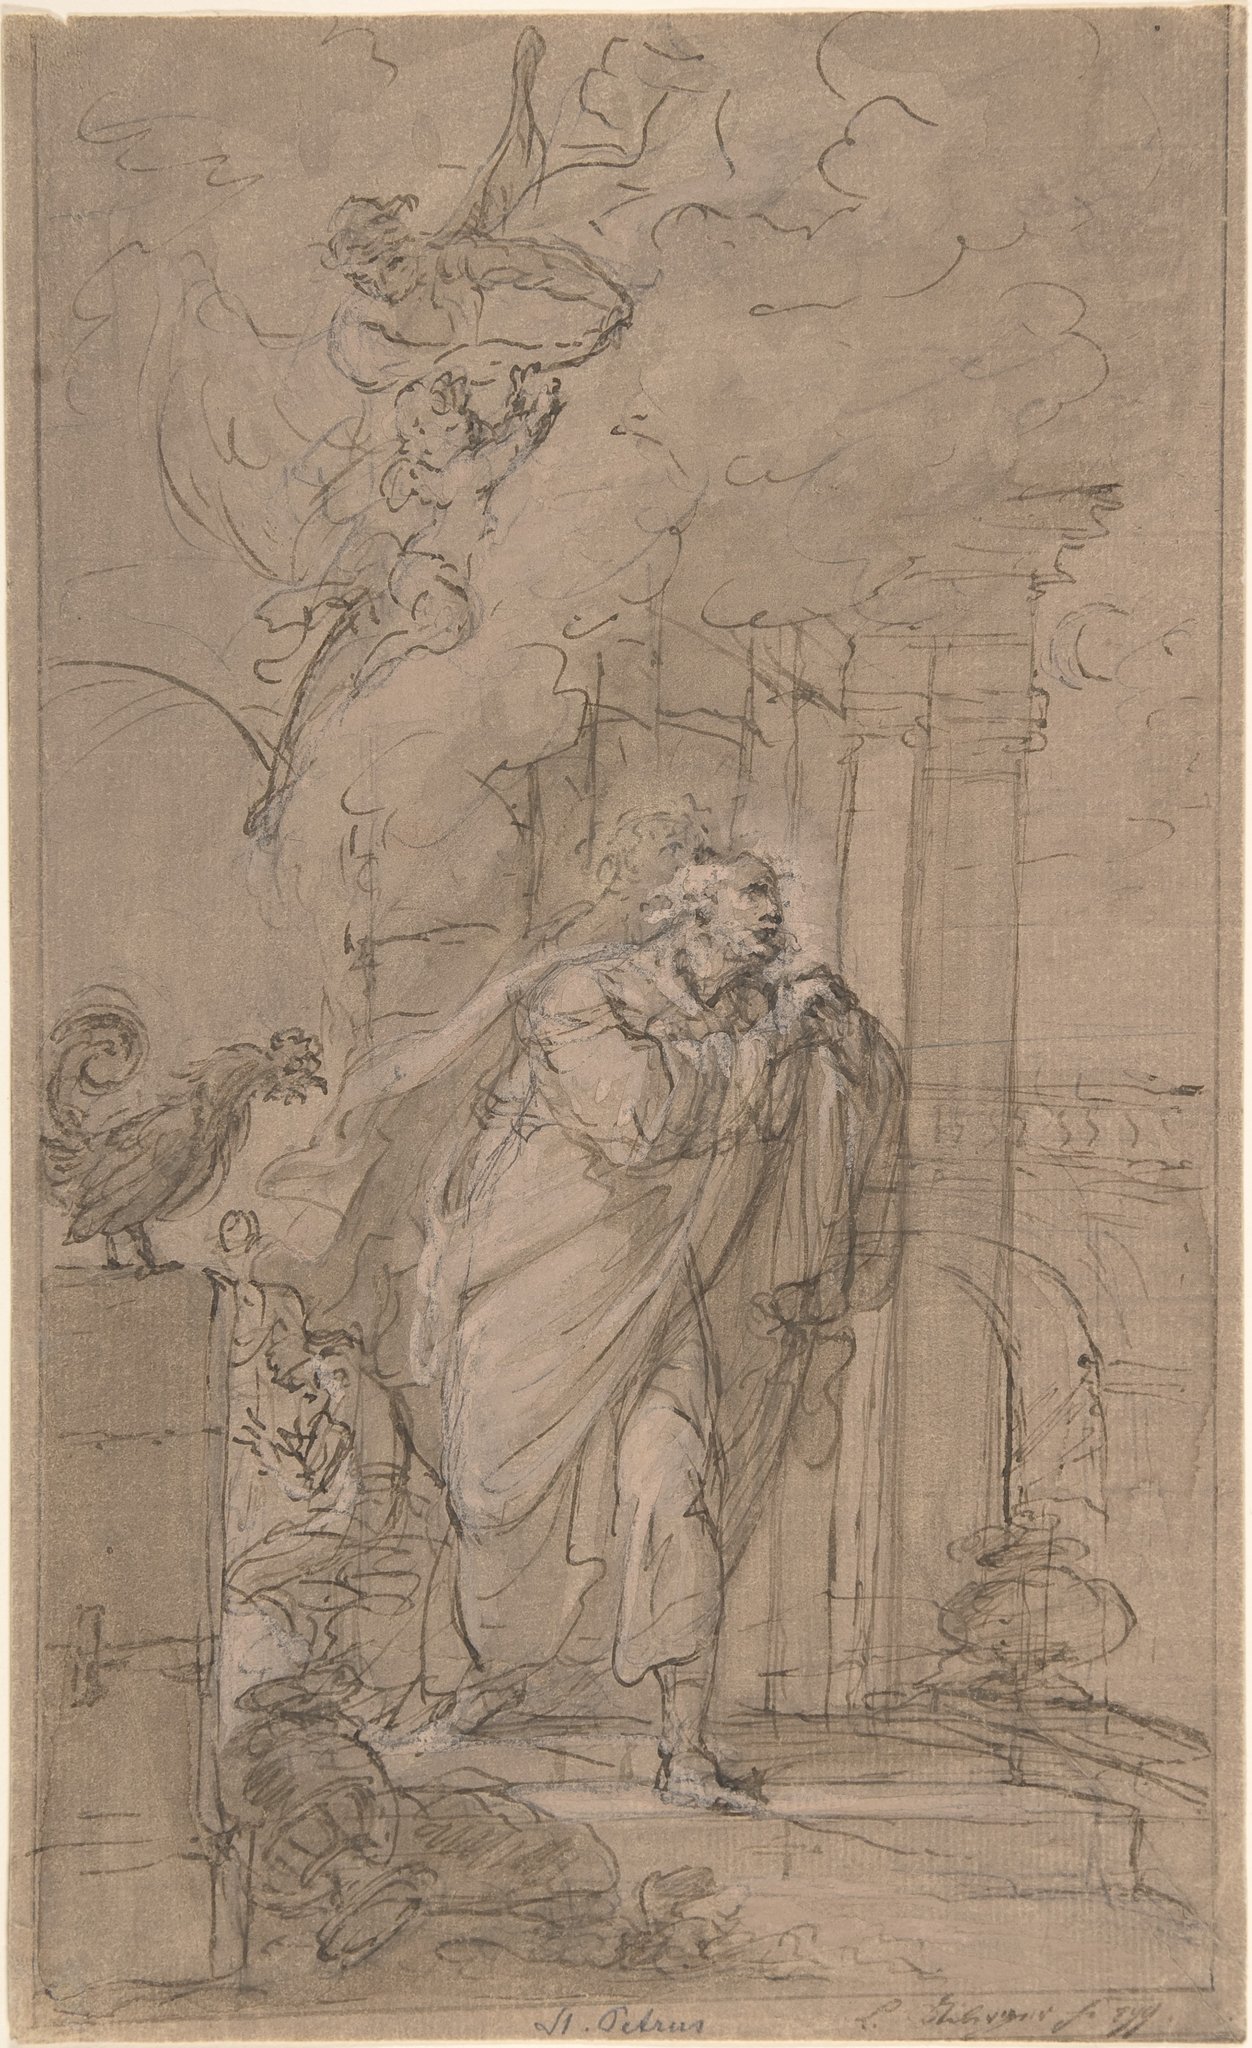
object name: drawing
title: Saint Peter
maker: lukas stipperger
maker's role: artist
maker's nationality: austrian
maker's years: 1755-1806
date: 1799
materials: chalk, graphite, ink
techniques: brush, heightening, pen, wash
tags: men,roosters,saint peter